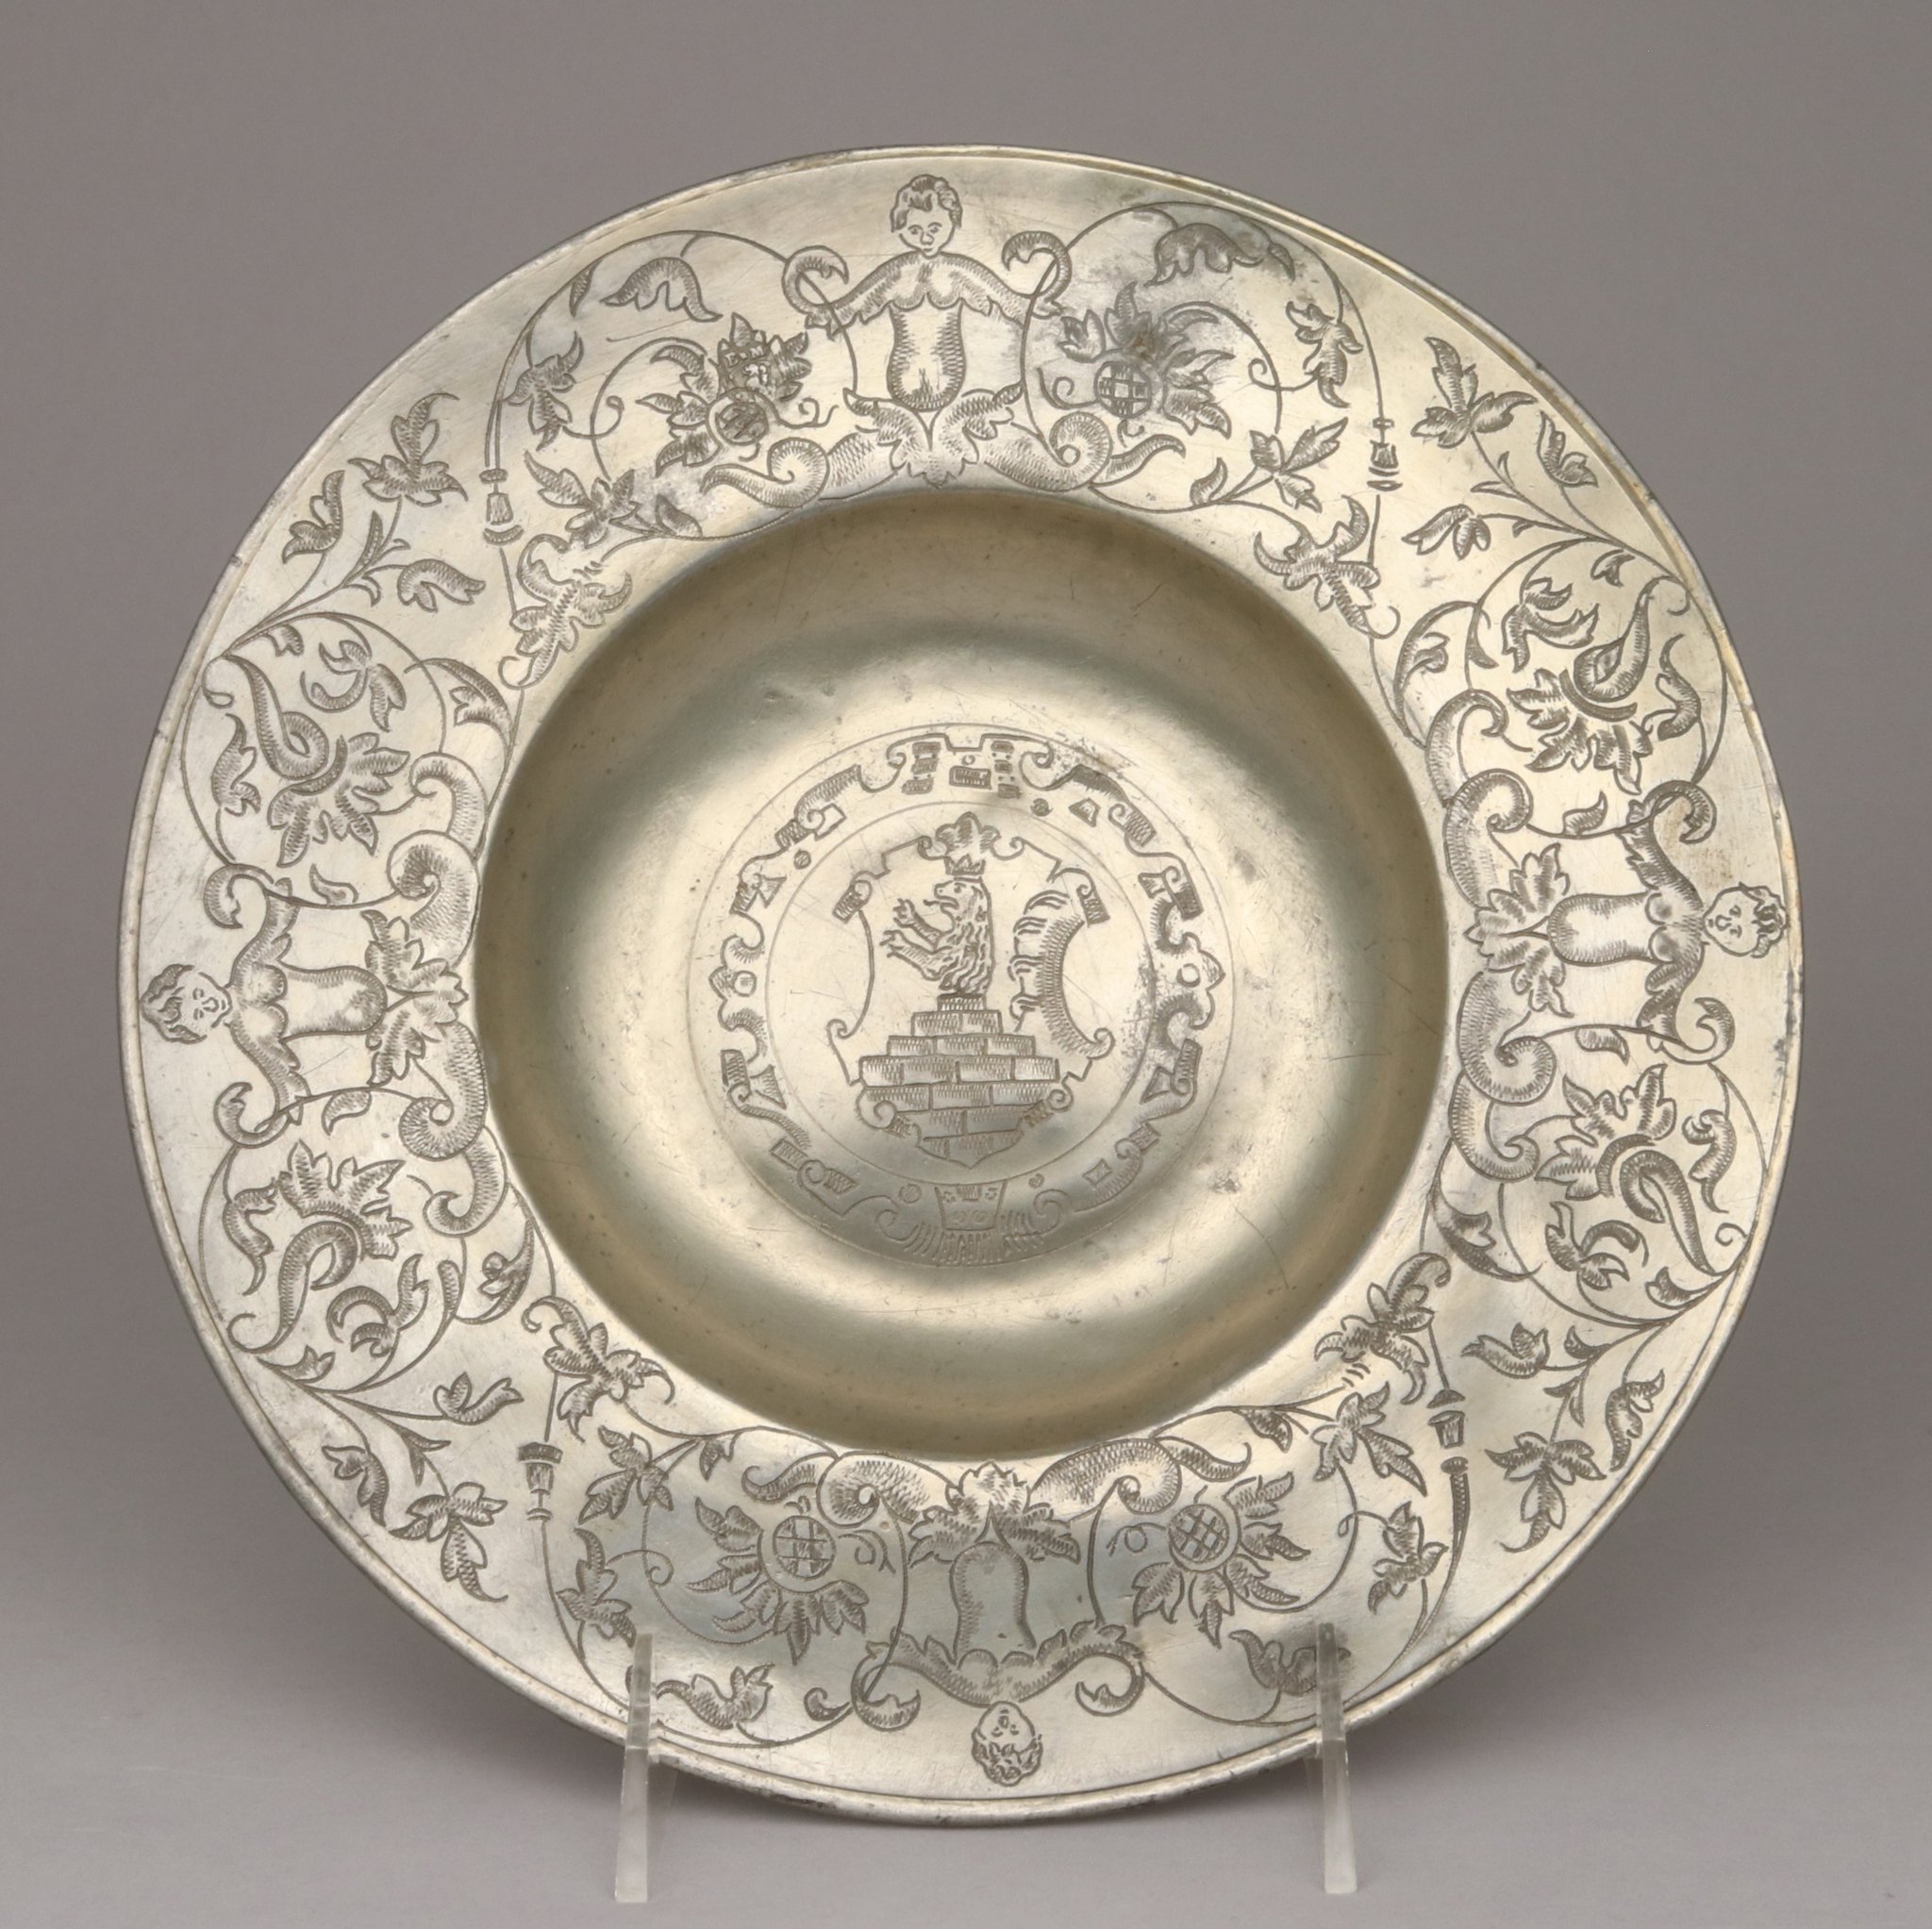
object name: plate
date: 1567-1600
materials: pewter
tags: coat of arms